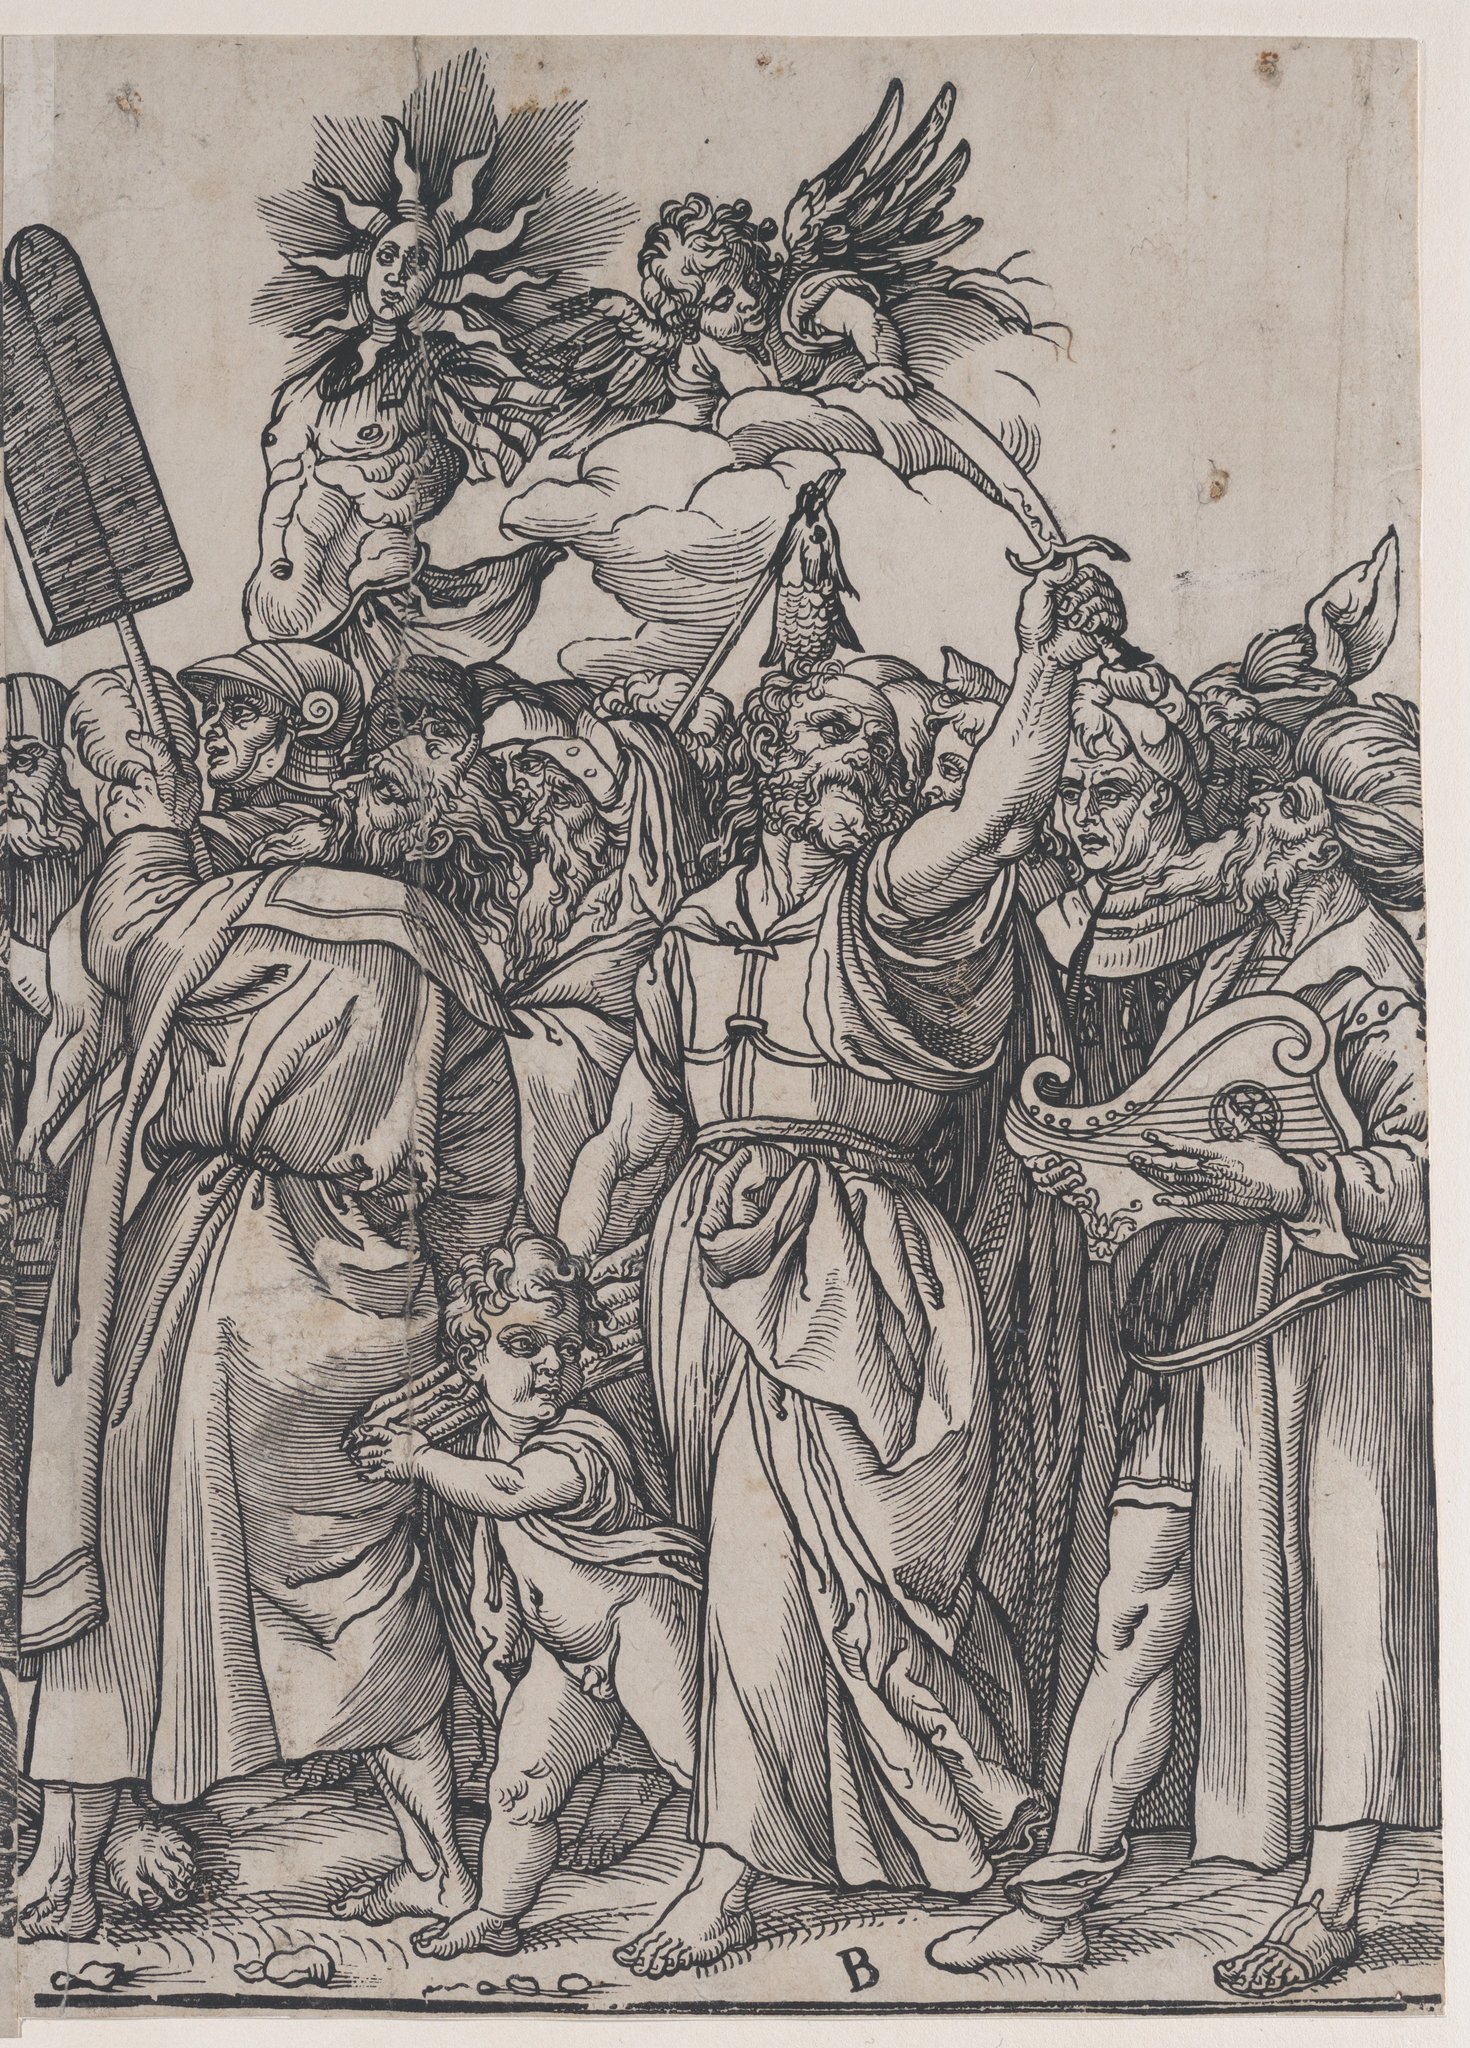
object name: print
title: Section B: Isaac, Noah and other figures, from "The Triumph of Christ"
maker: andrea andreani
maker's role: artist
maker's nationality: italian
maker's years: 1558-1629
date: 1836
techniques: lithograph, woodcut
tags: men,christ